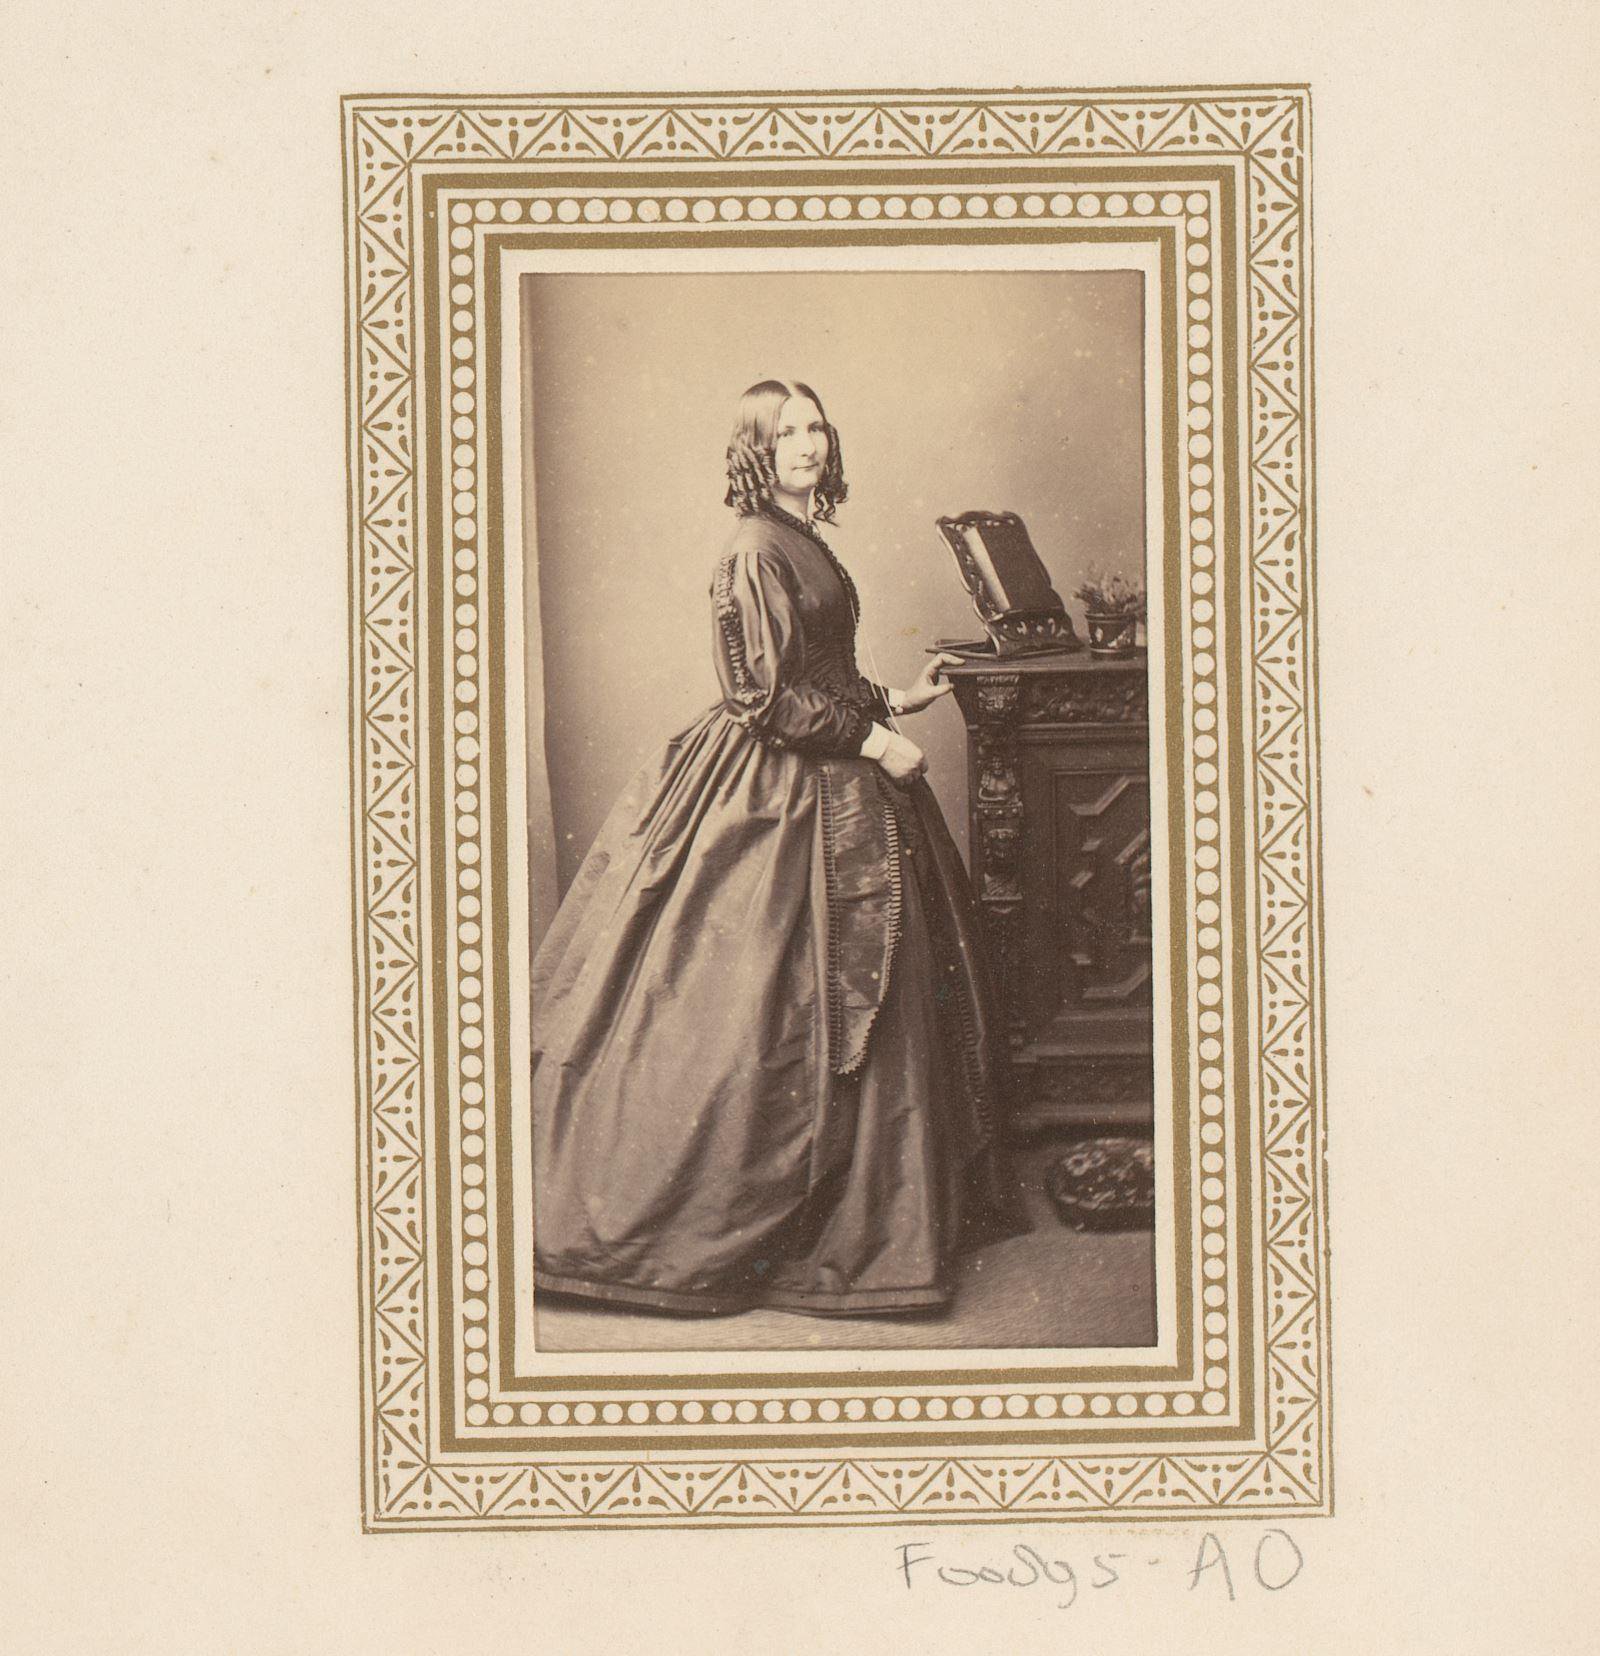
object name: carte de visite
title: Portret van een staande vrouw bij een kast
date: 1863-1875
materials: cardboard, photographic support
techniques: albumen print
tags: furniture for storage, historical persons, standing figure - aa - female human figure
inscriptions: inscription: ‘G. & R. Lavis/ Photographers &/ Miniature Painters/ 135, Regent St./ W.’